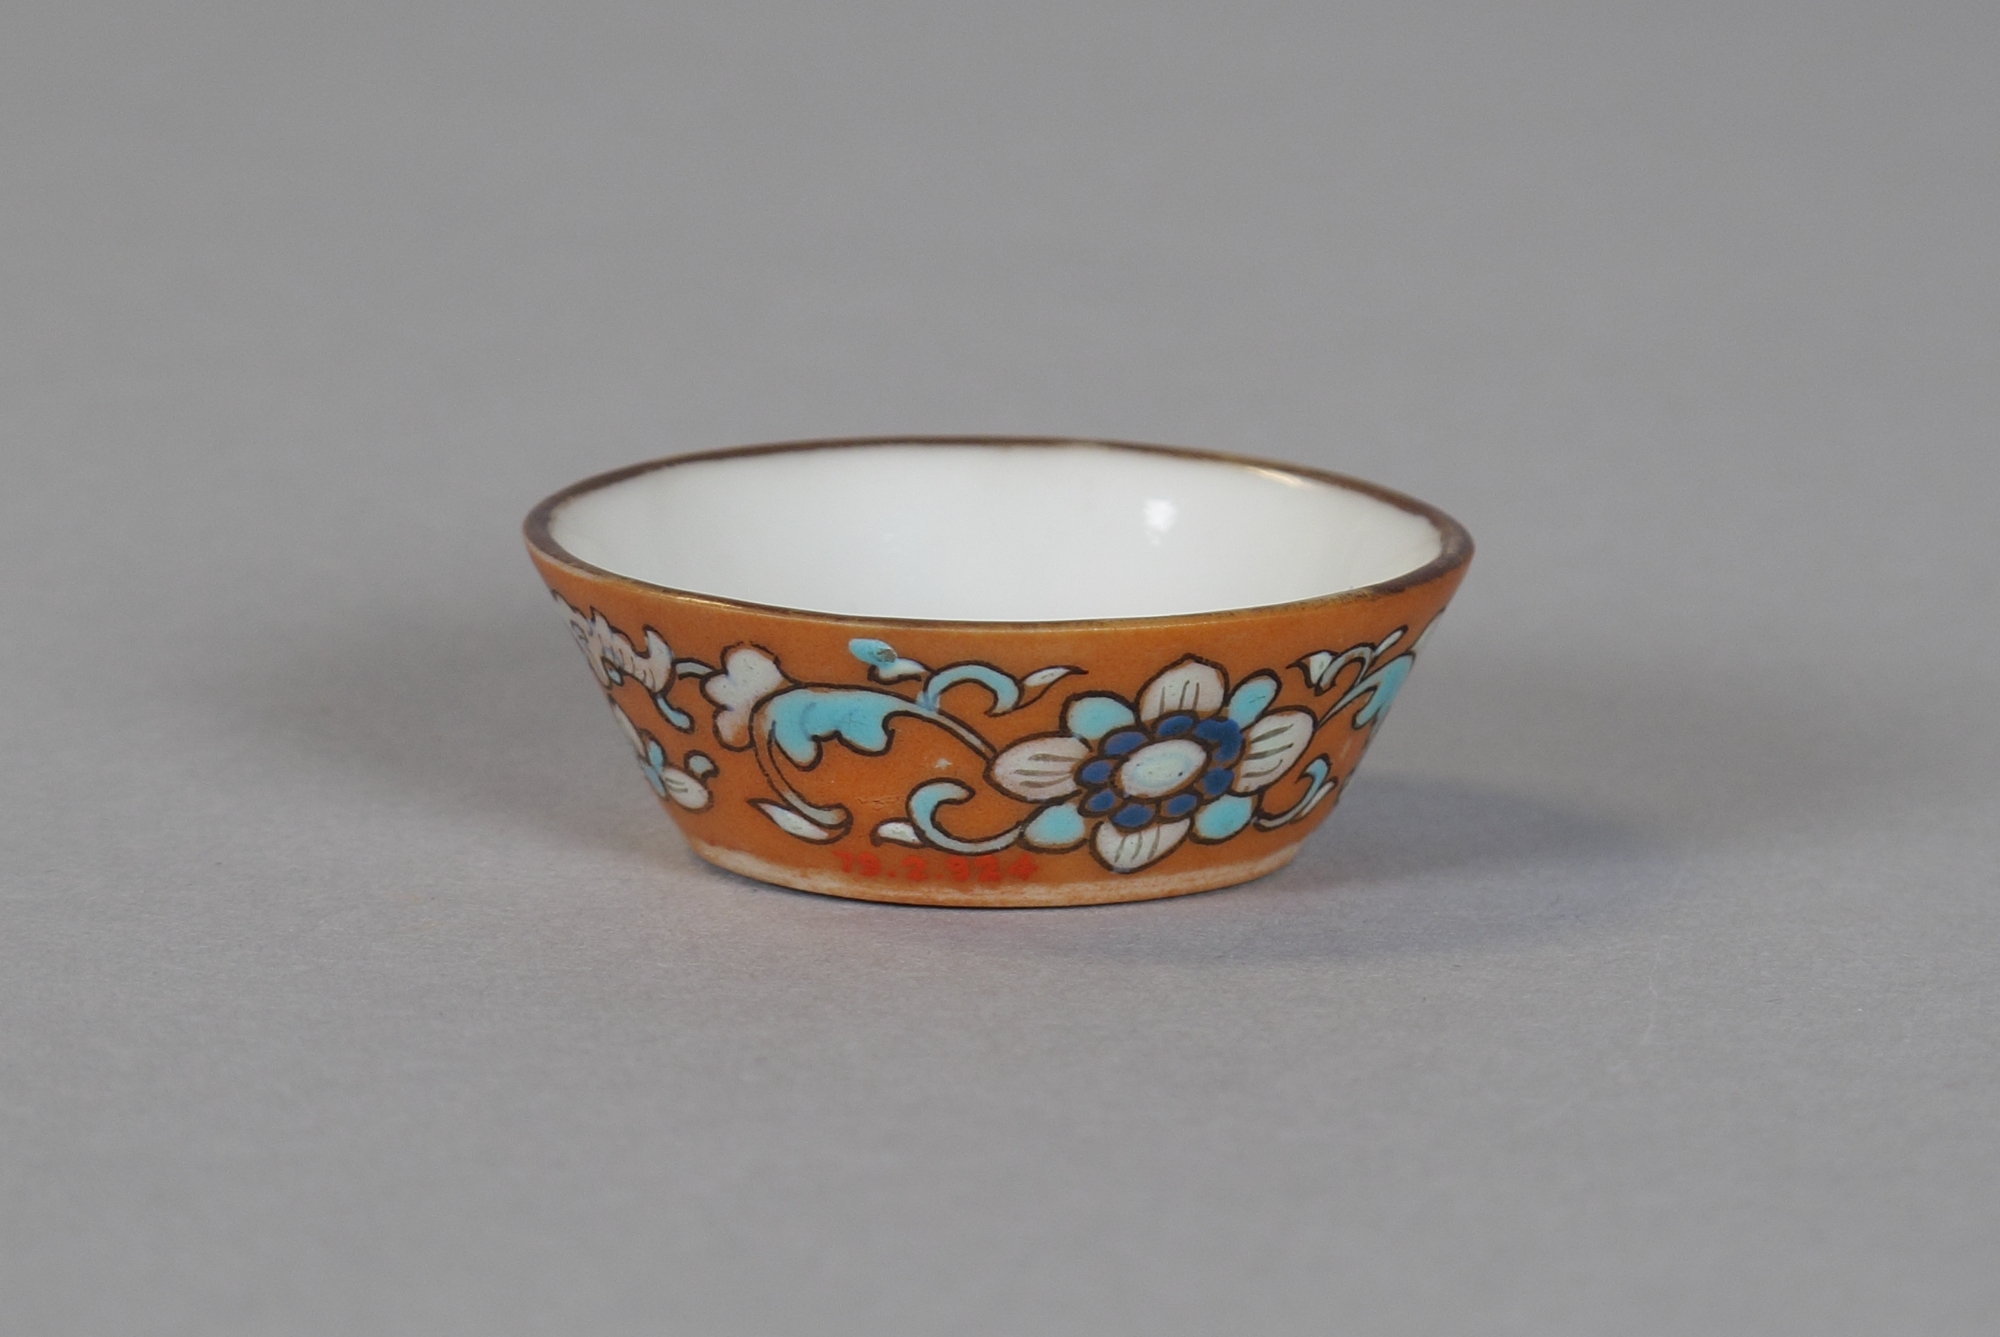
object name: cup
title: Cup (from a set of eight)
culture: chinese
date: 1644-1911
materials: enamel, glaze, iron, porcelain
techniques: overglaze, painting, polychrome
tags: flowers